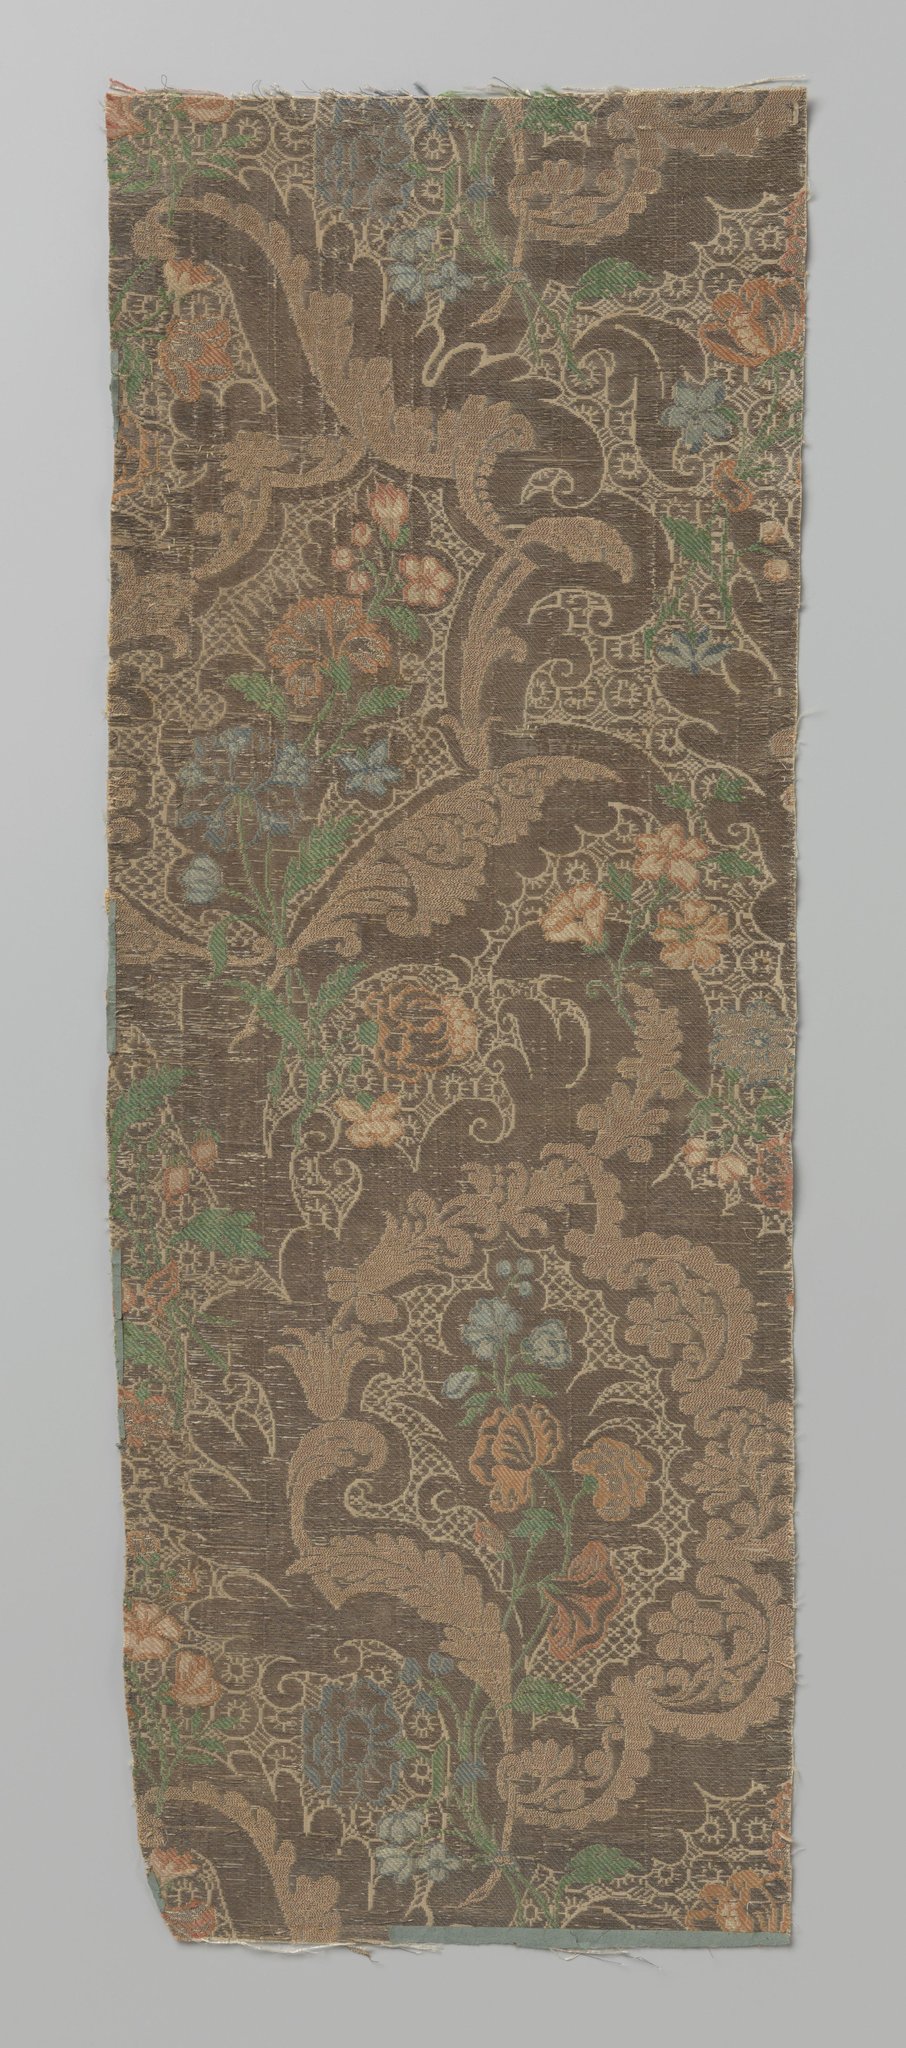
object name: zijdebrokaat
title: Zijden brokaat versierd met bloemen en bladeren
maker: Anonymous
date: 1725-1775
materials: silk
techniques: brocade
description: Zijden brokaat, bestaande uit twee aan elkaar genaaide rechthoekige fragmenten. Groene takken met zalmkleurige en met blauwe bloemen in een asymmetrische omlijsting van zilveren rozet en kelkbloemen en lange bladeren op een grond van horizontaal geweven zilverdraad.